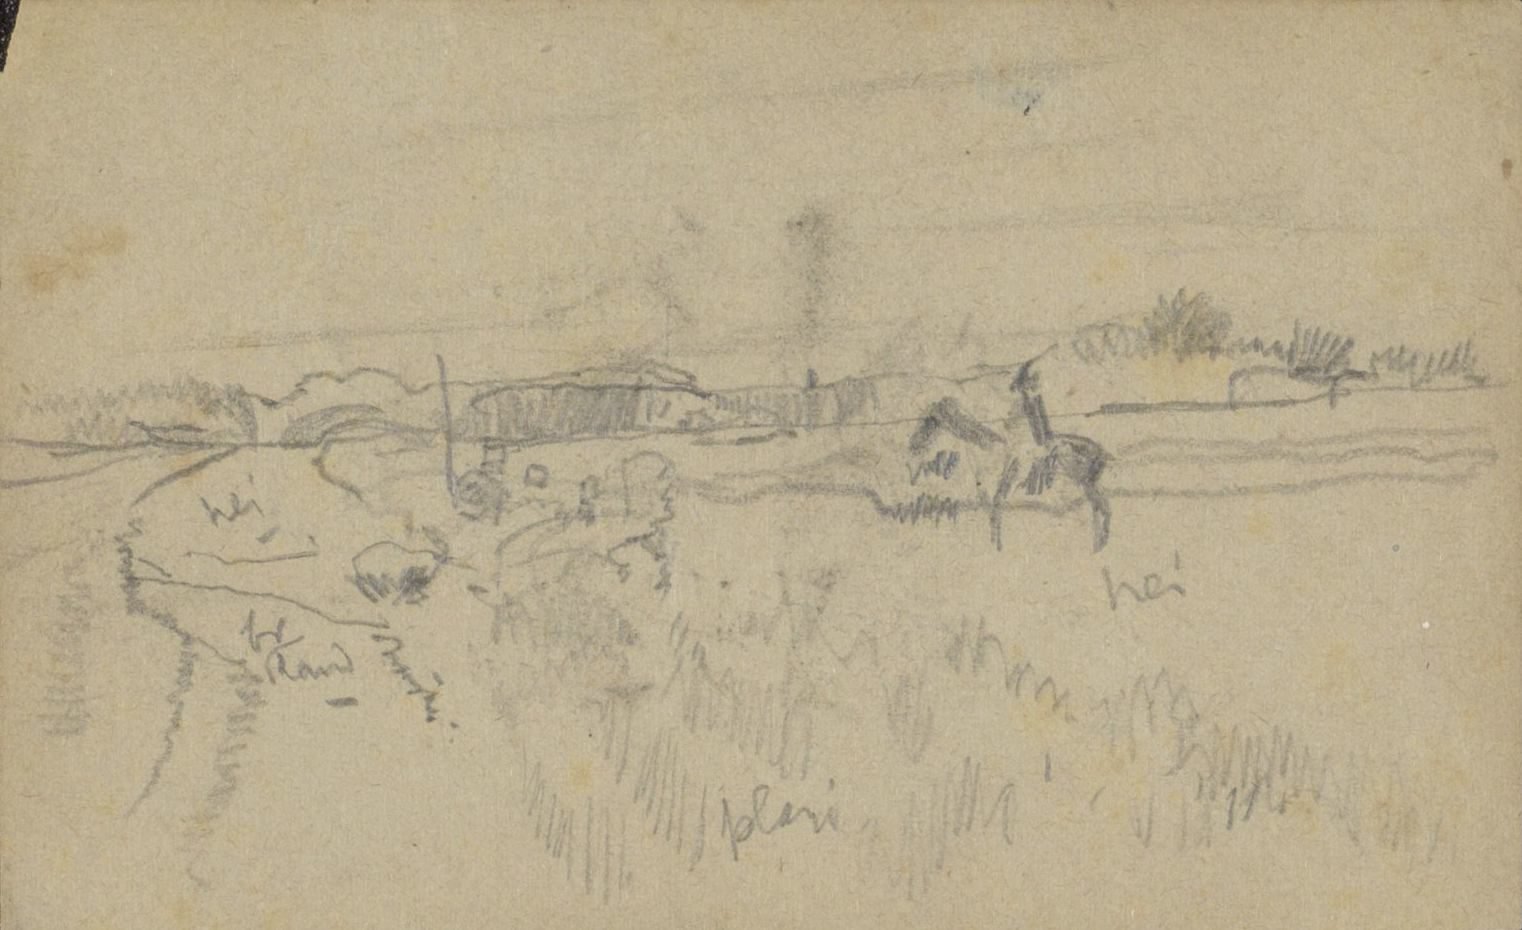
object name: drawing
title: Ruiter op een heide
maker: george hendrik breitner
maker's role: draughtsman, painter, print maker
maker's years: 1857-1923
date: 1882-1912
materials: paper, pencil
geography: gelderland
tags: private soldier (+ land forces), plain (+ landscape with figures, staffage), horse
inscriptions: annotation: ‘hei’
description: Voor de ruiter zitten soldaten. Mogelijk is het een manoeuvreterrein.